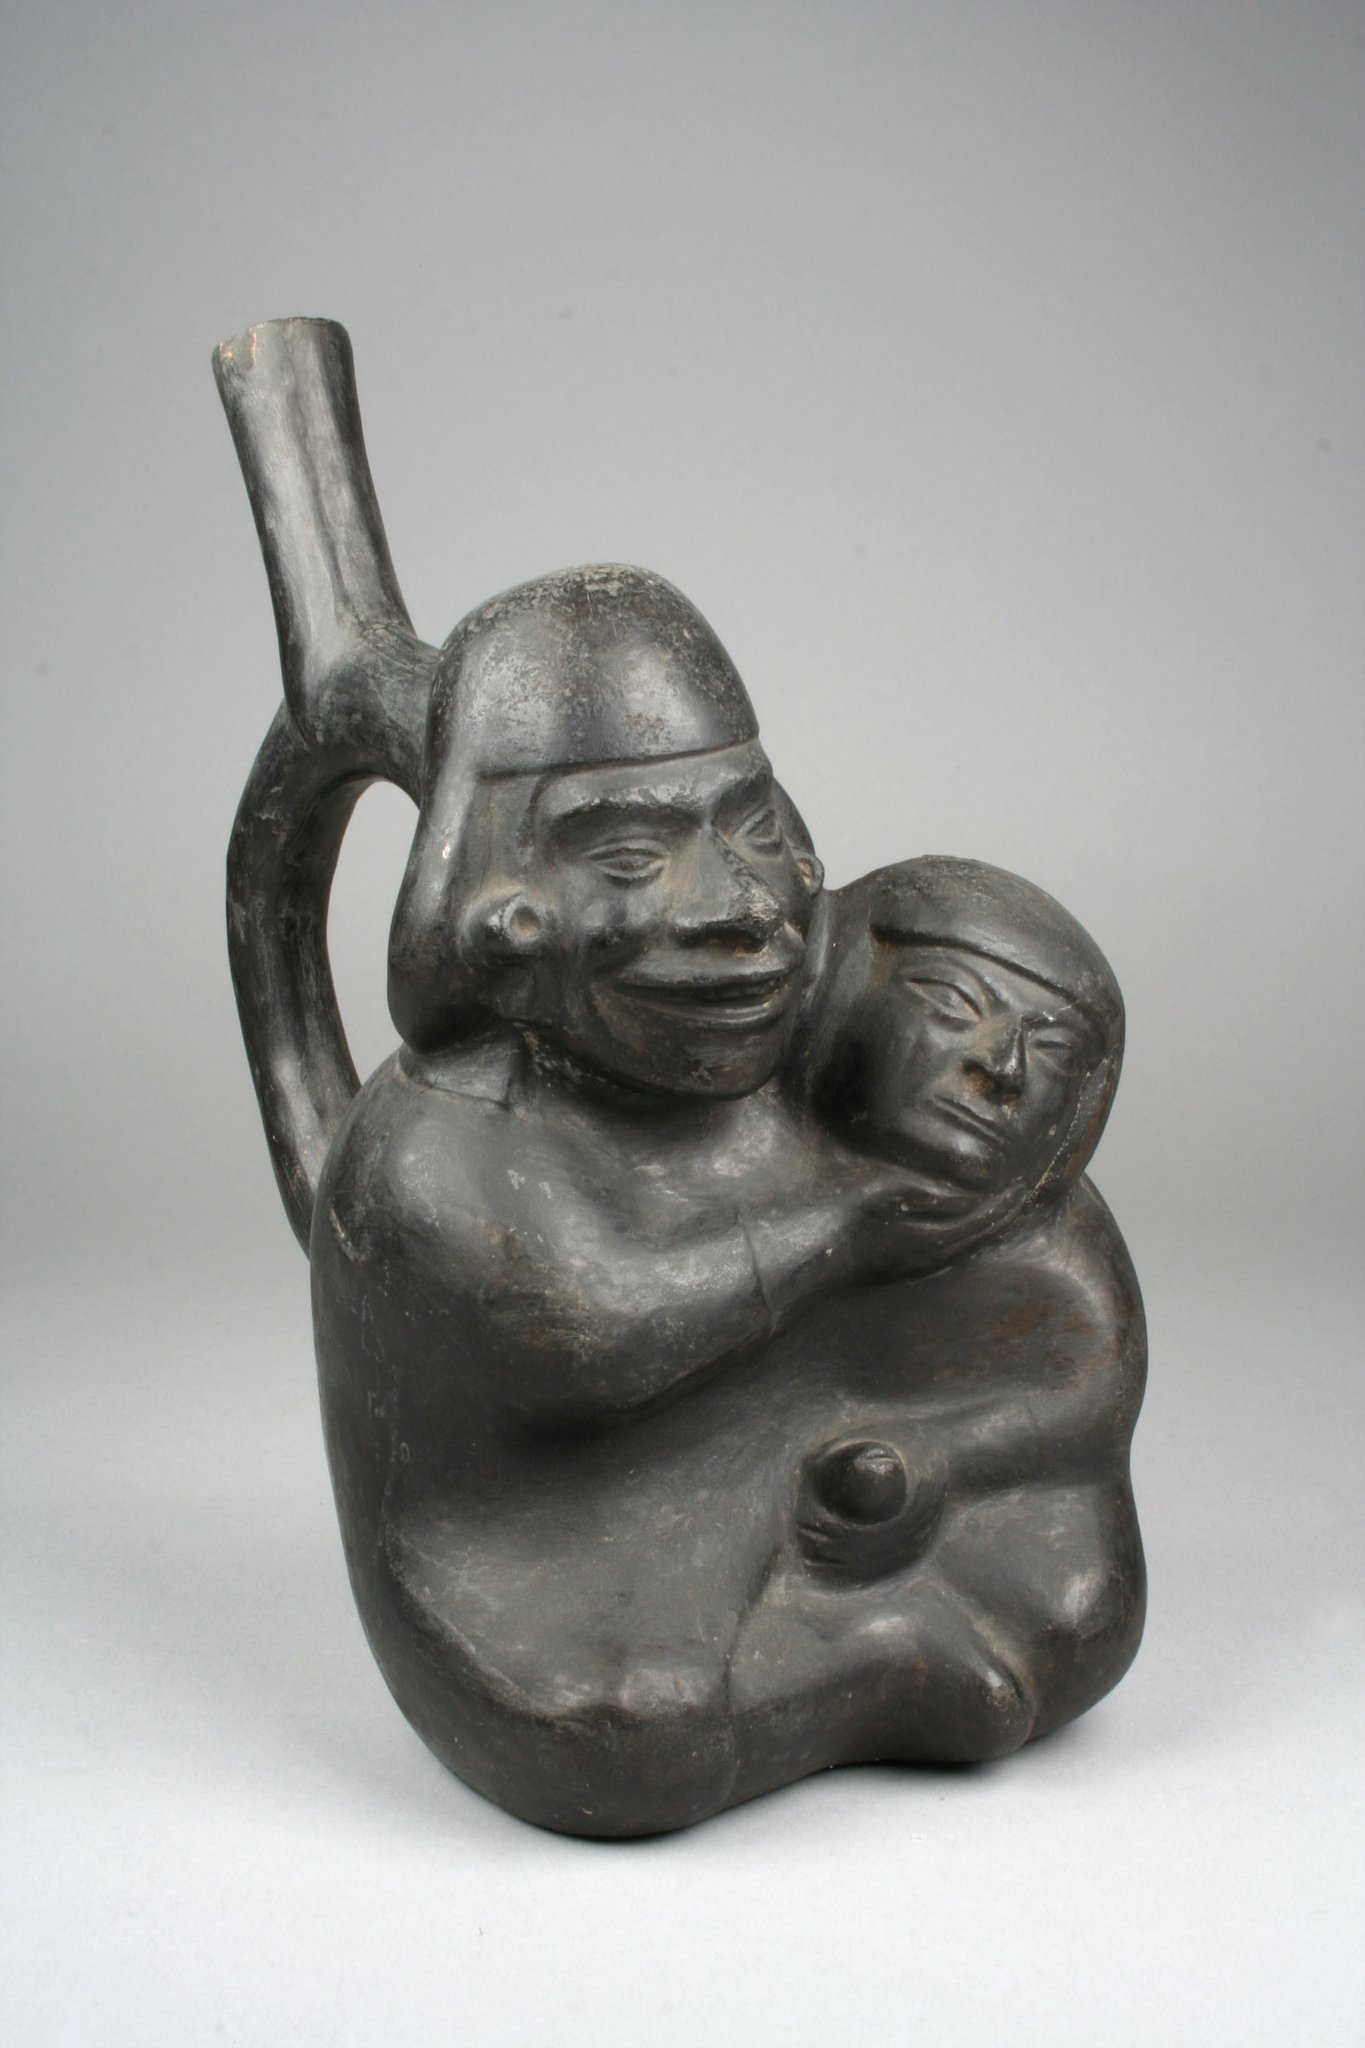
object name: bottle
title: Stirrup Spout Bottle with Couple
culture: moche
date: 201-700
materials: ceramic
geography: peru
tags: couples